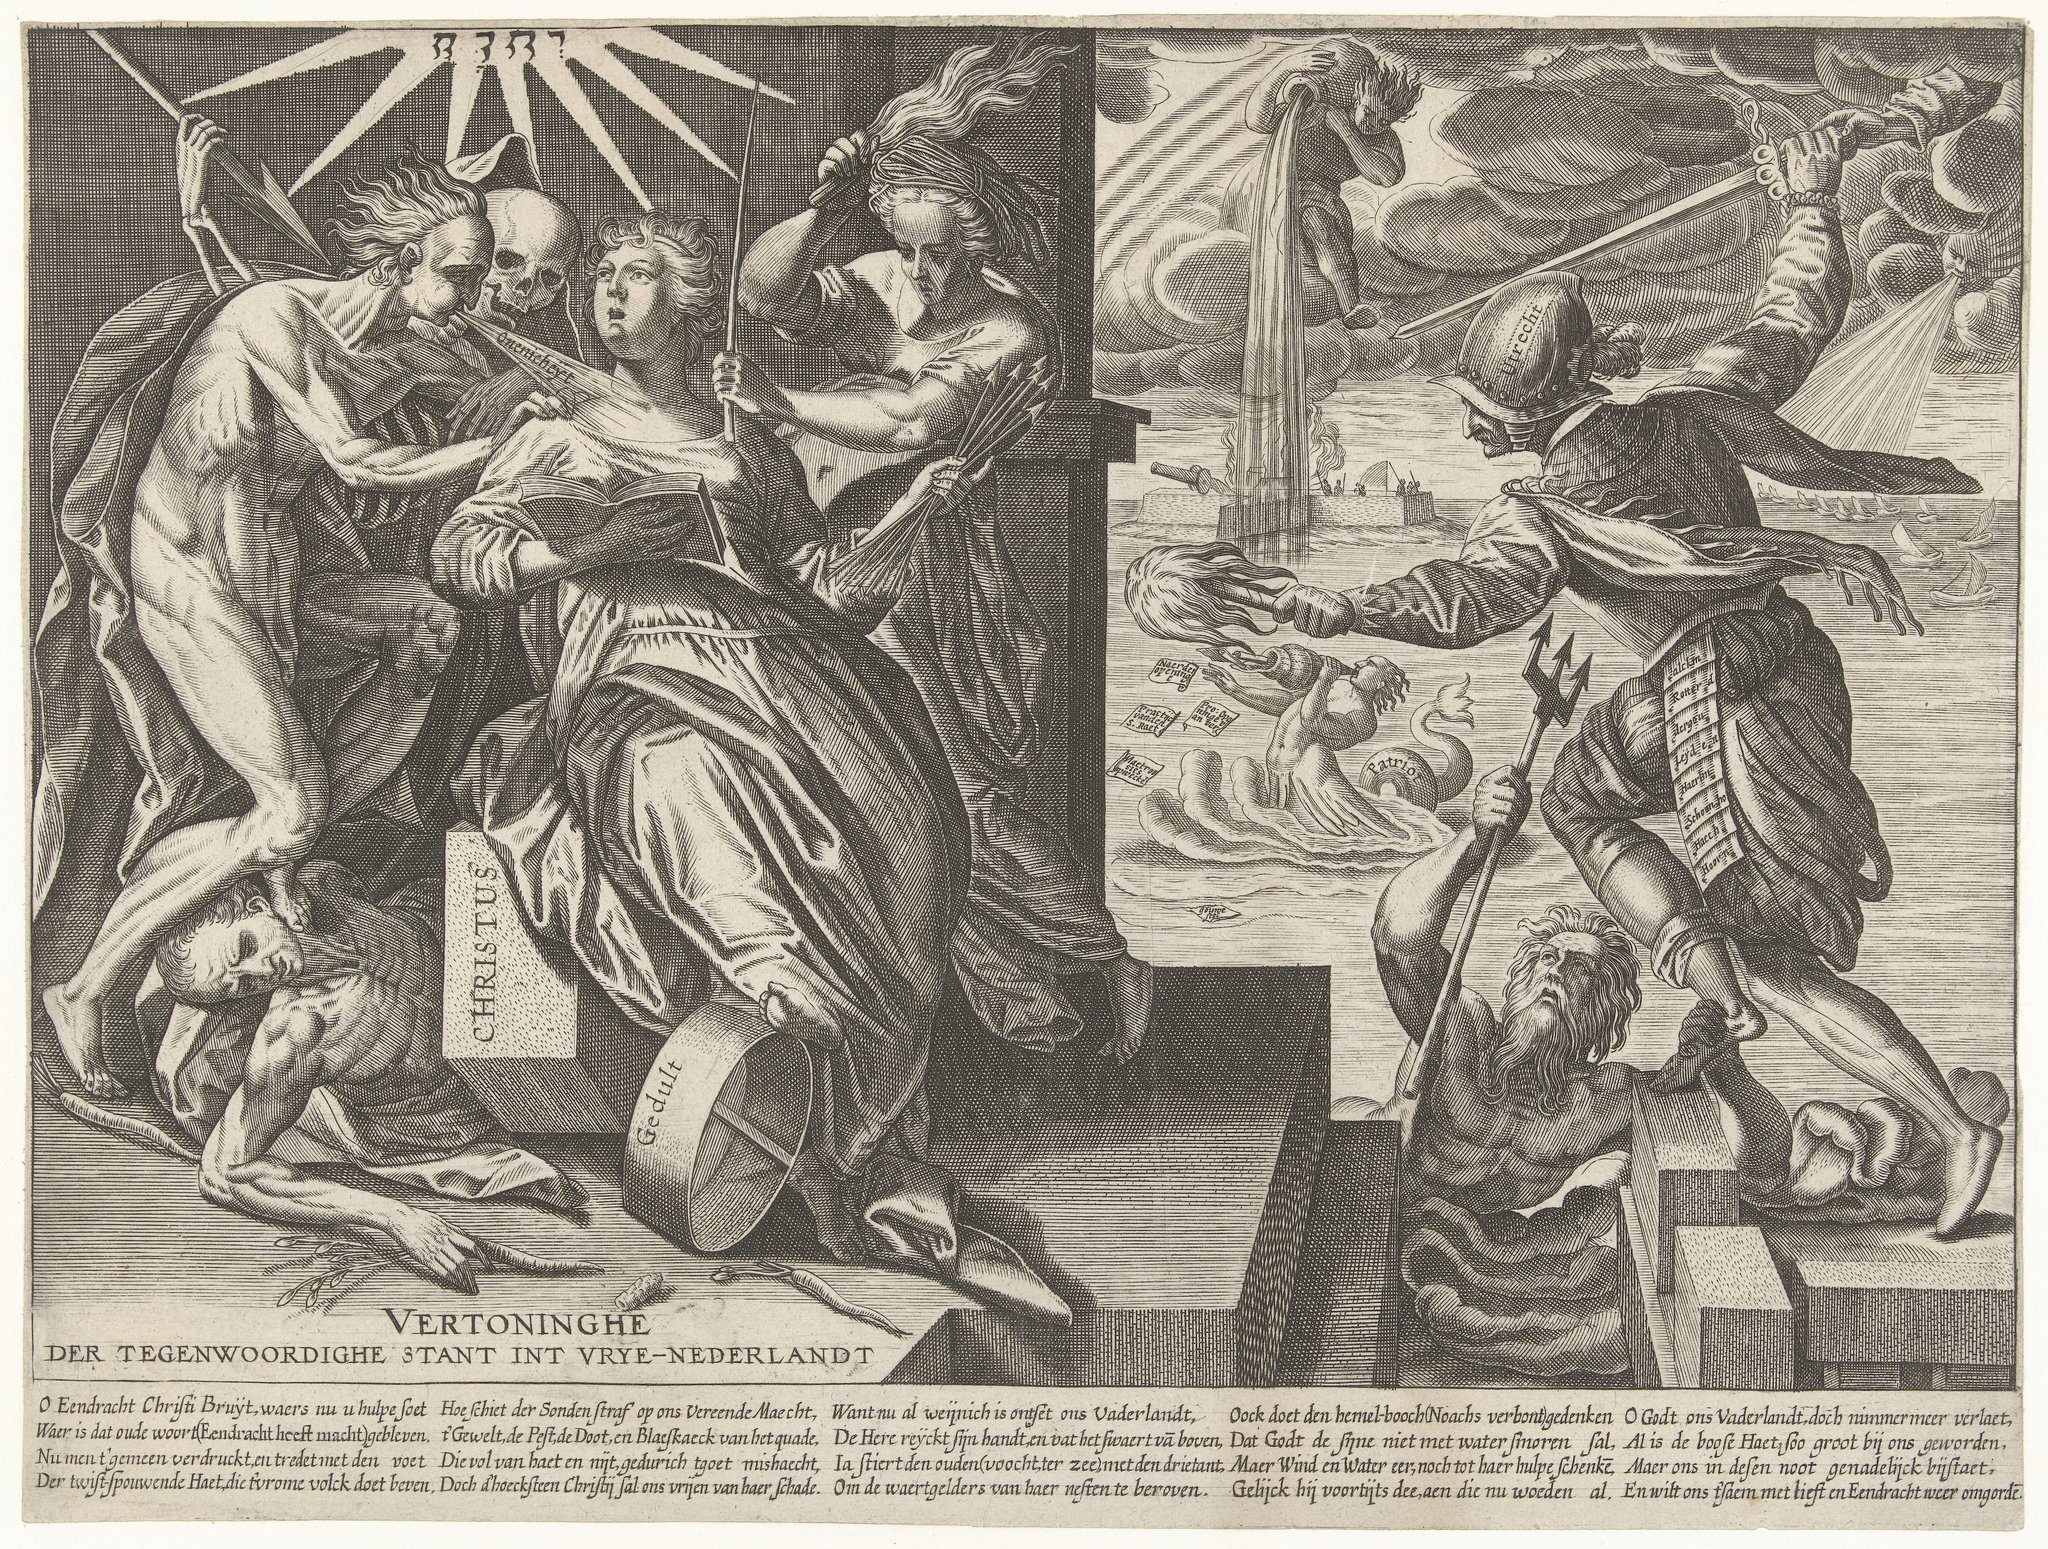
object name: print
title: Allegorie op de bestandstwisten, 1618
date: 1618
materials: paper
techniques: engraving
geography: northern netherlands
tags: personifications of countries, nations, states, districts, etc., netherlands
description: Allegorie op de bestandstwisten, 1618. De Nederlandse Maagd wordt aangevallen door een soldaat gemerkt op zijn helm als Utrecht (waardgelder) met aan zijn rok de namen van de remonstrantse steden in Holland. Zijn opgeheven hand met zwaard wordt door de hand van God uit de hemel tegen gehouden. De maagd zit op de hoeksteen Christus en wordt tegelijkertijd belaagd door Onenigheid, Dood en Razernij. In de zee blaast een triton (Patriot) contraremonstrantse pamfletten uit zijn hoorn. Met onderschrift van 5 verzen van 4 regels in het Nederlands.